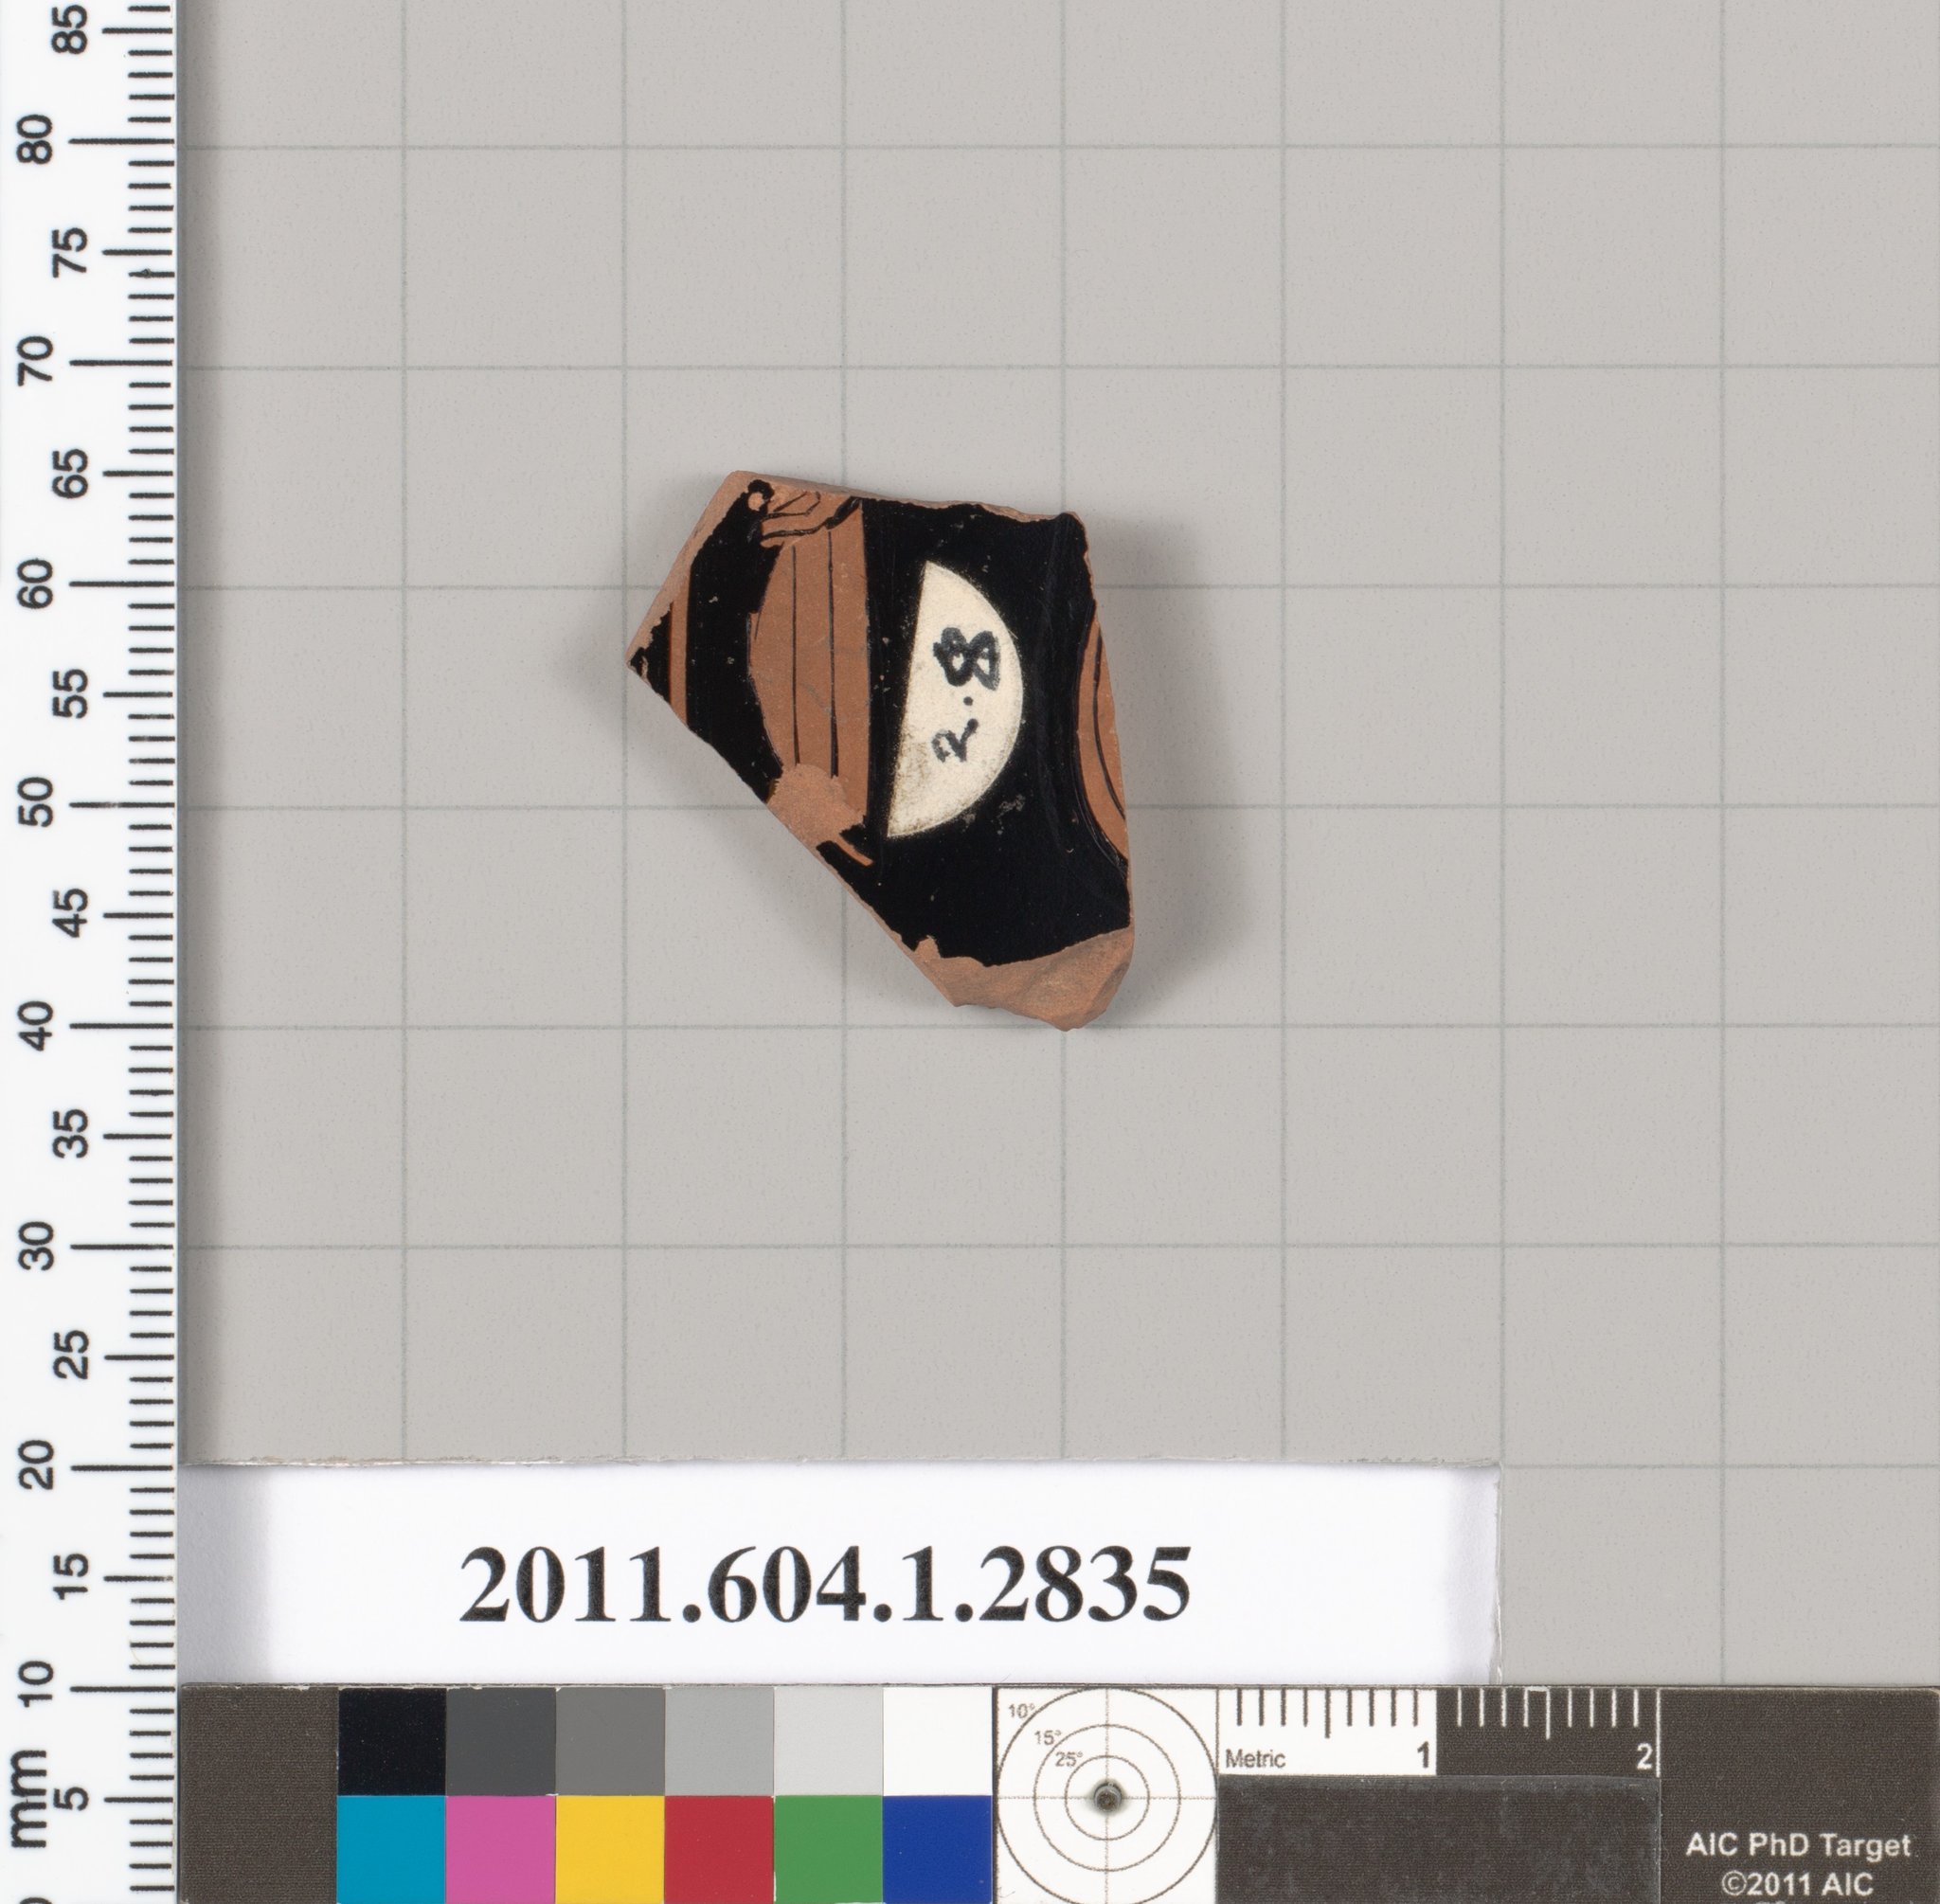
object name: kylix fragment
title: Terracotta fragment of a kylix (drinking cup)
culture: greek, attic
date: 510-490 BCE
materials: terracotta